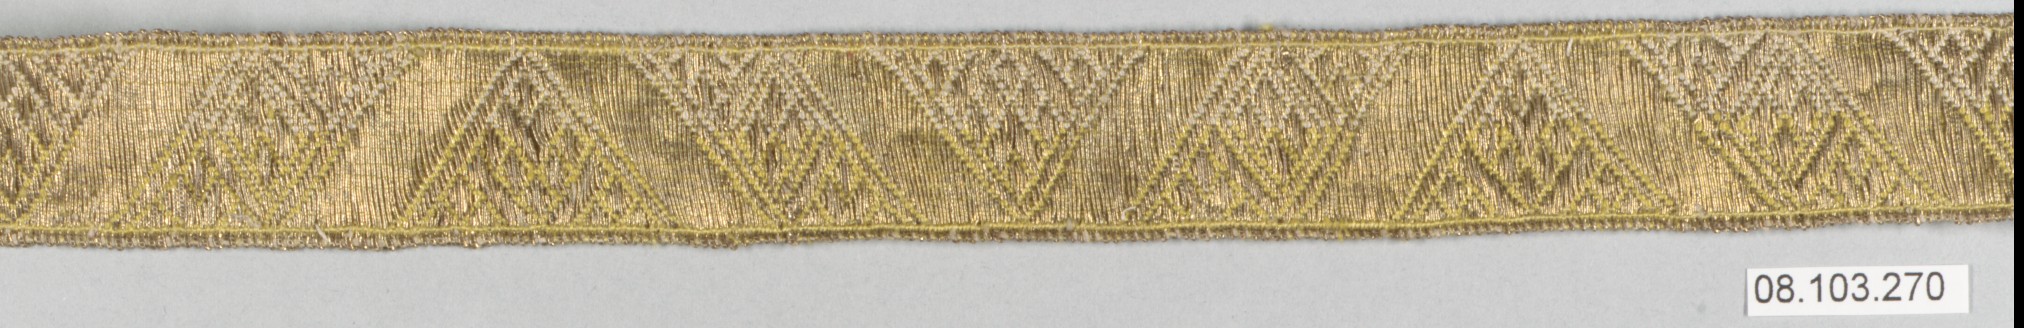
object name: galloon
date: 1601-1800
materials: metal thread